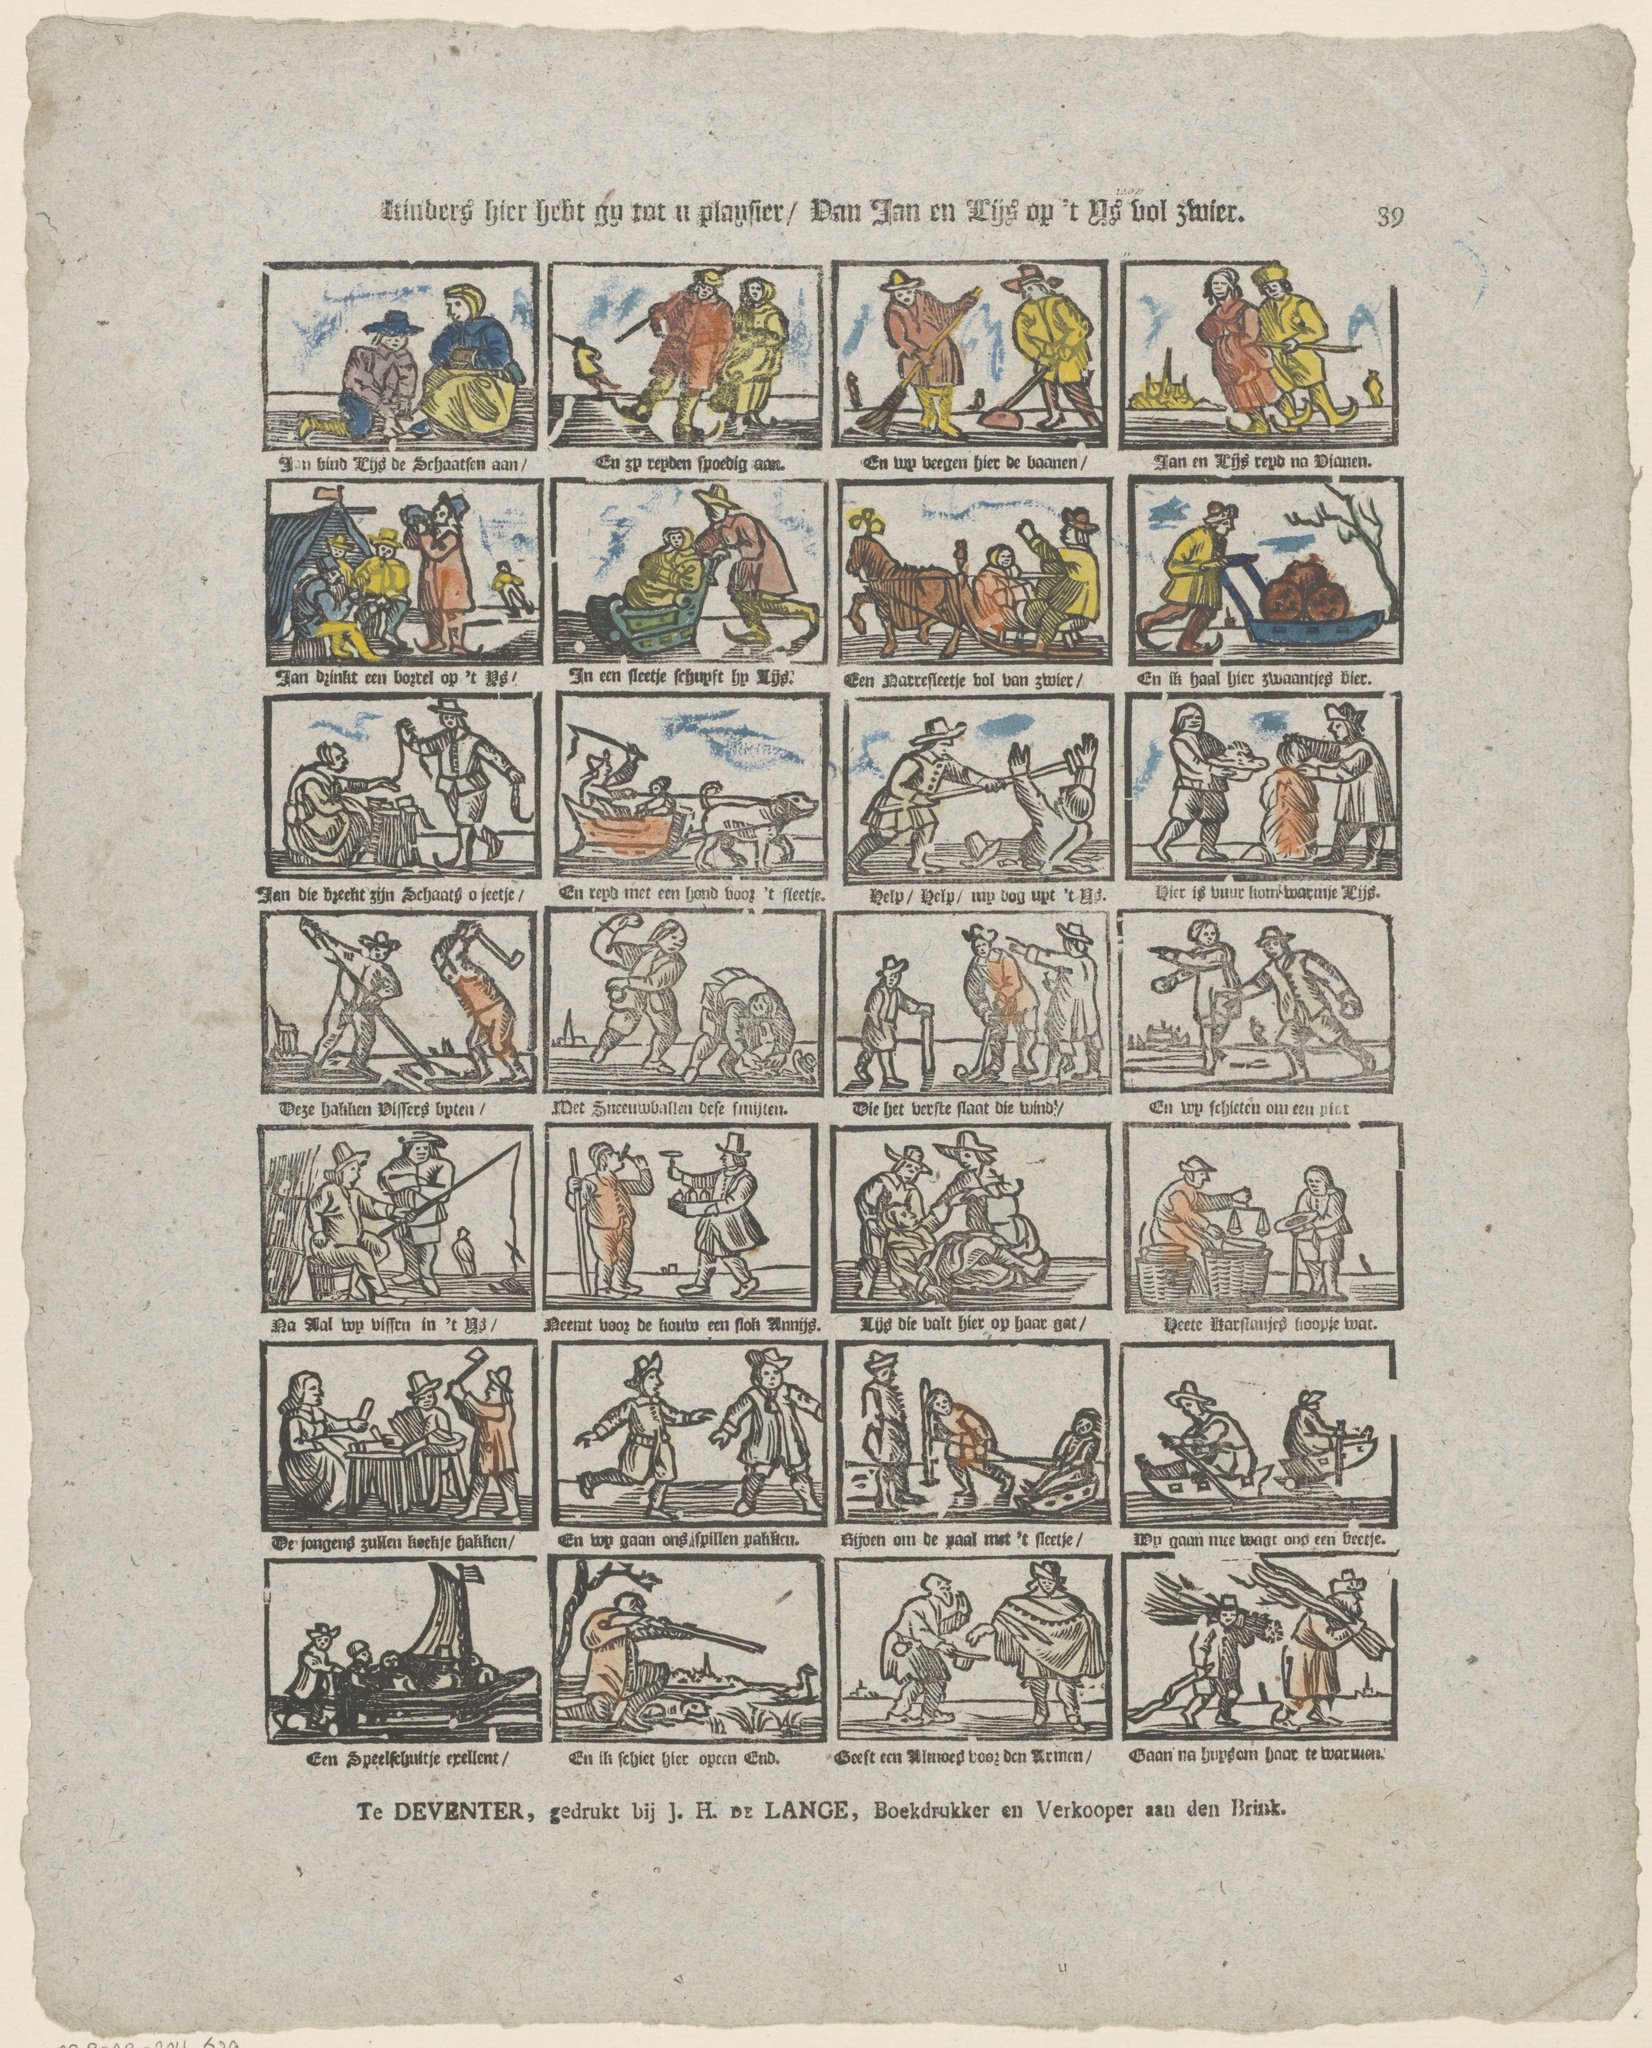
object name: popular print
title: Kinders hier hebt gy tot u playsier / Van Jan en Lijs op 't ys vol zwier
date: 1787-1822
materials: paper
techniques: colour, letterpress printing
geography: netherlands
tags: winter sports, winter ~ human activities (the four seasons of the year), skates (winter sports), fishing (sports), sledge, sleigh (winter sports), playing with snow and ice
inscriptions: collector's mark: Lugt 2760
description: Blad met 28 voorstellingen van winterse taferelen, van onder andere mensen die schaatsen, sleeën en ijsvissen. Onder elke afbeelding een tweeregelig vers. Genummerd rechtsboven: 39.